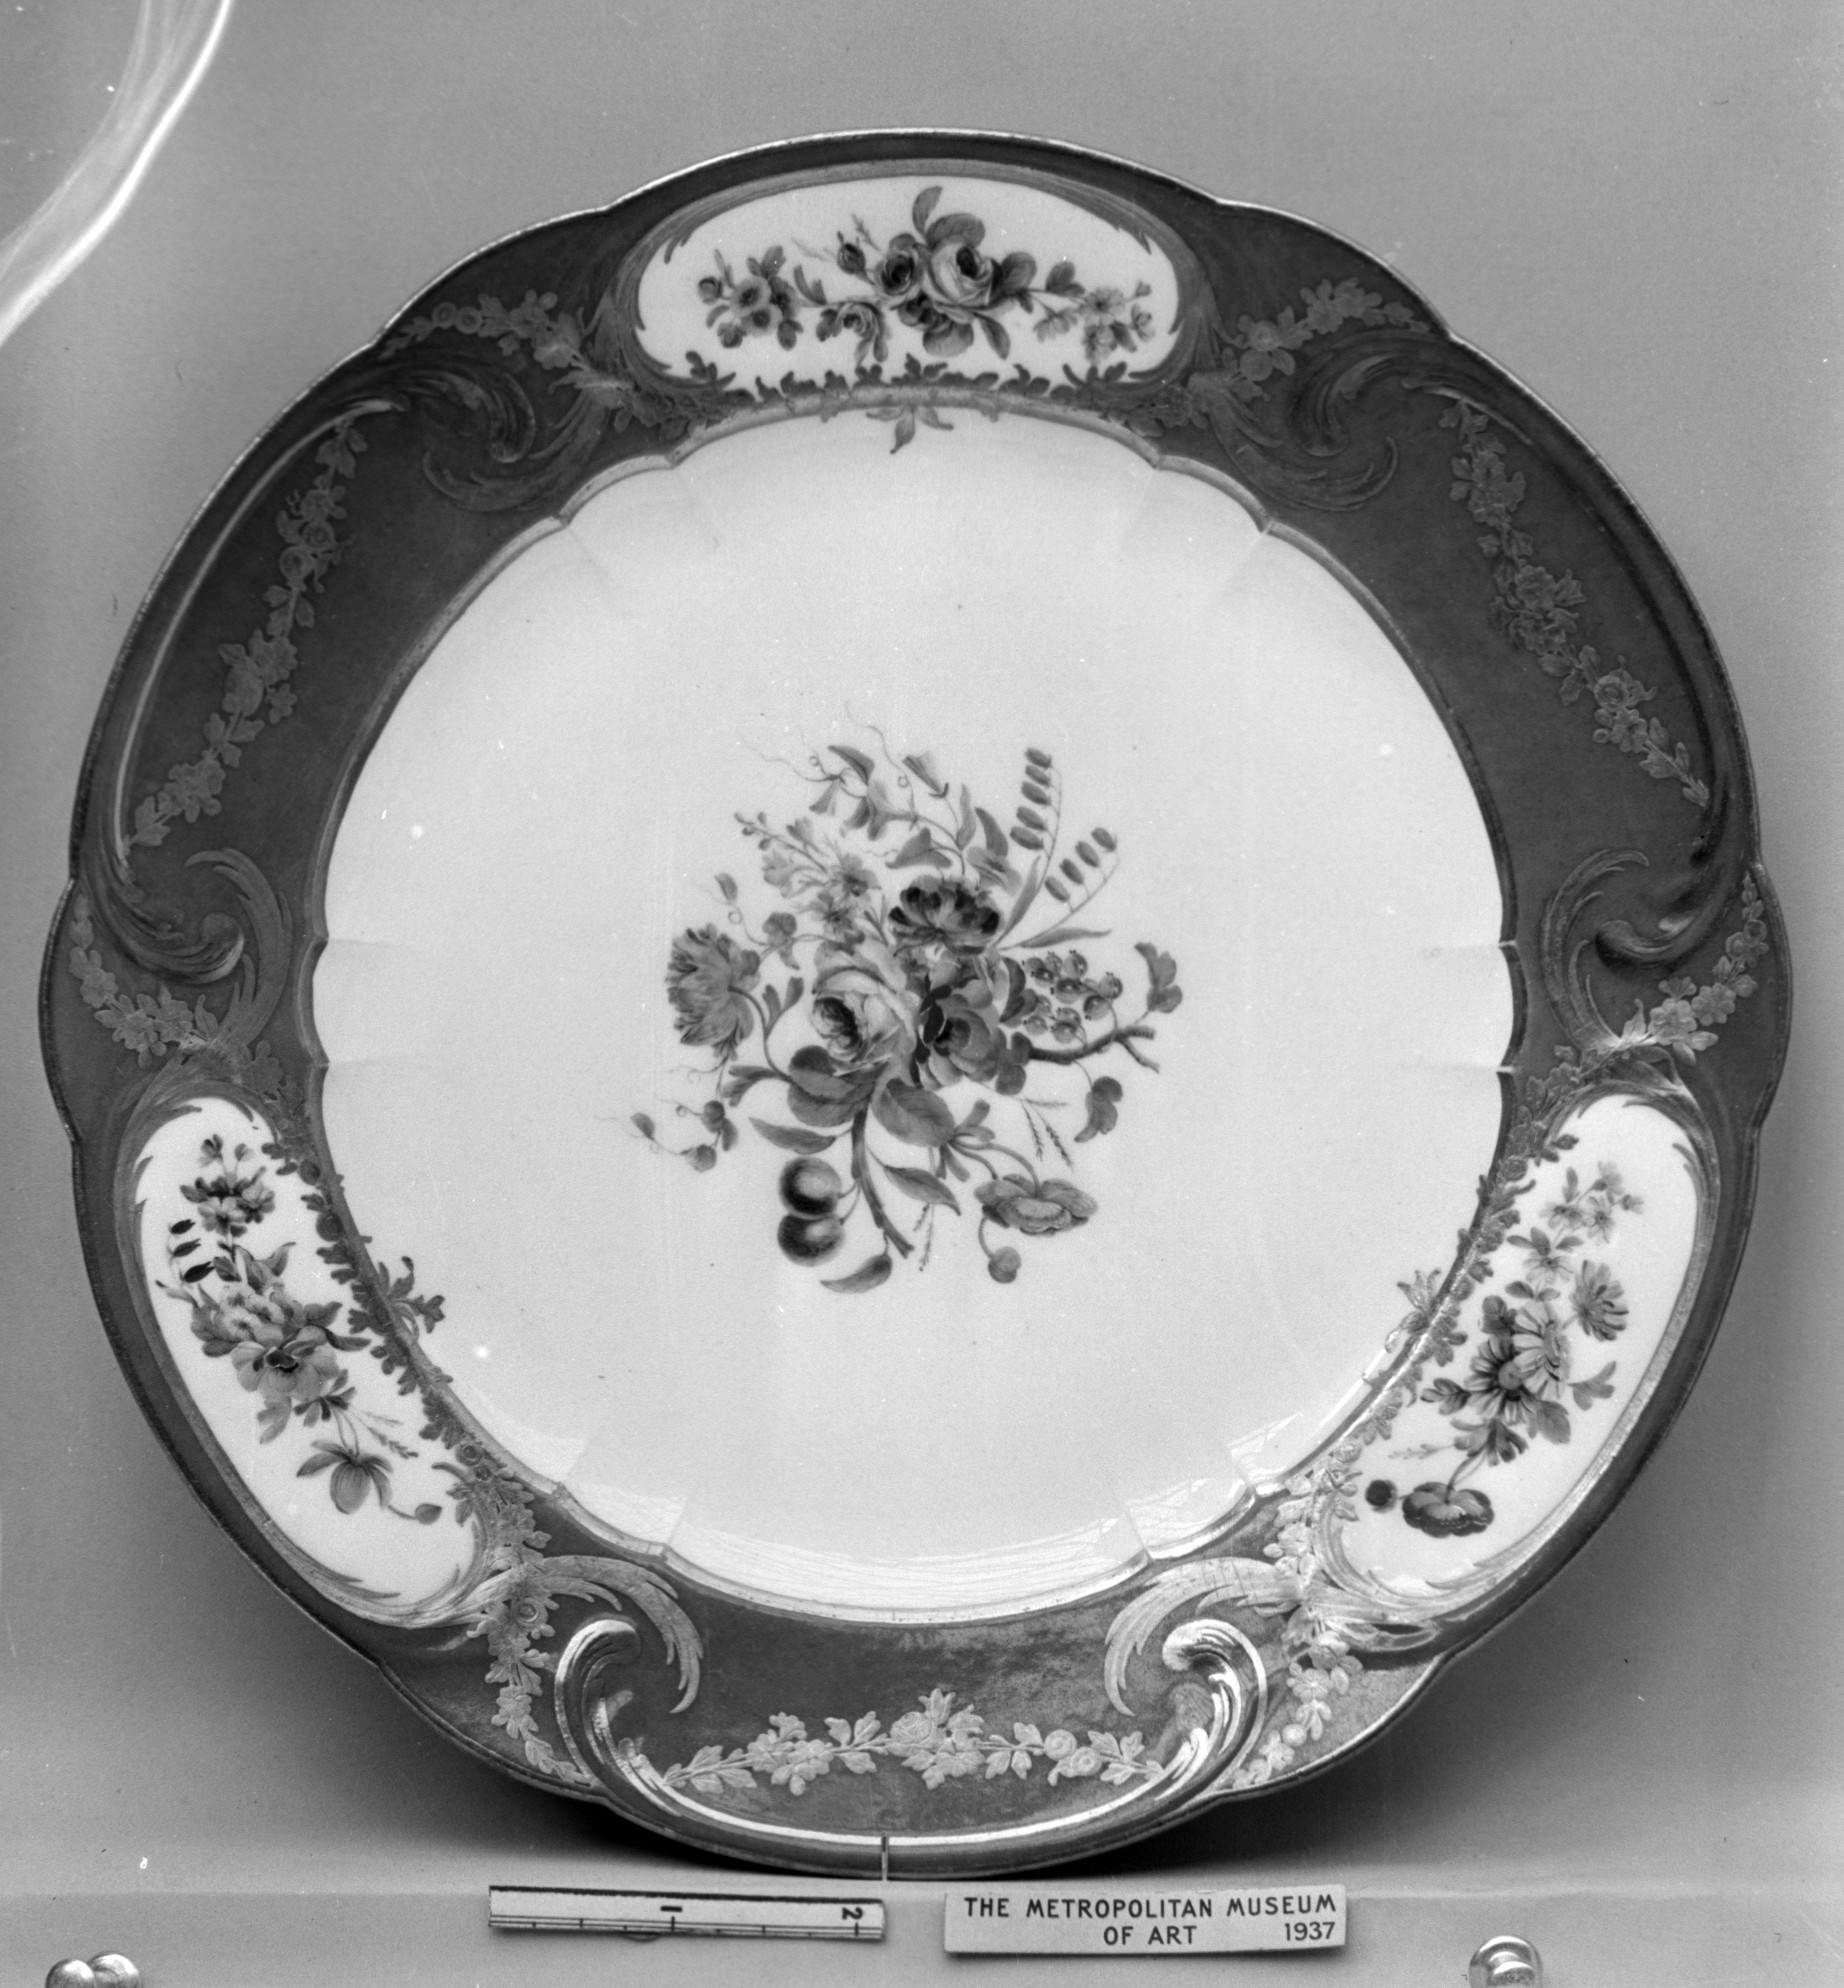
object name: plate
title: Plate (Assiette à palmes) (1 of 102) (part of a service)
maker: sèvres manufactory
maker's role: manufactory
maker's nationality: french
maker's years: 1740-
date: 1780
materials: soft paste porcelain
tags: garlands,fruit,flowers